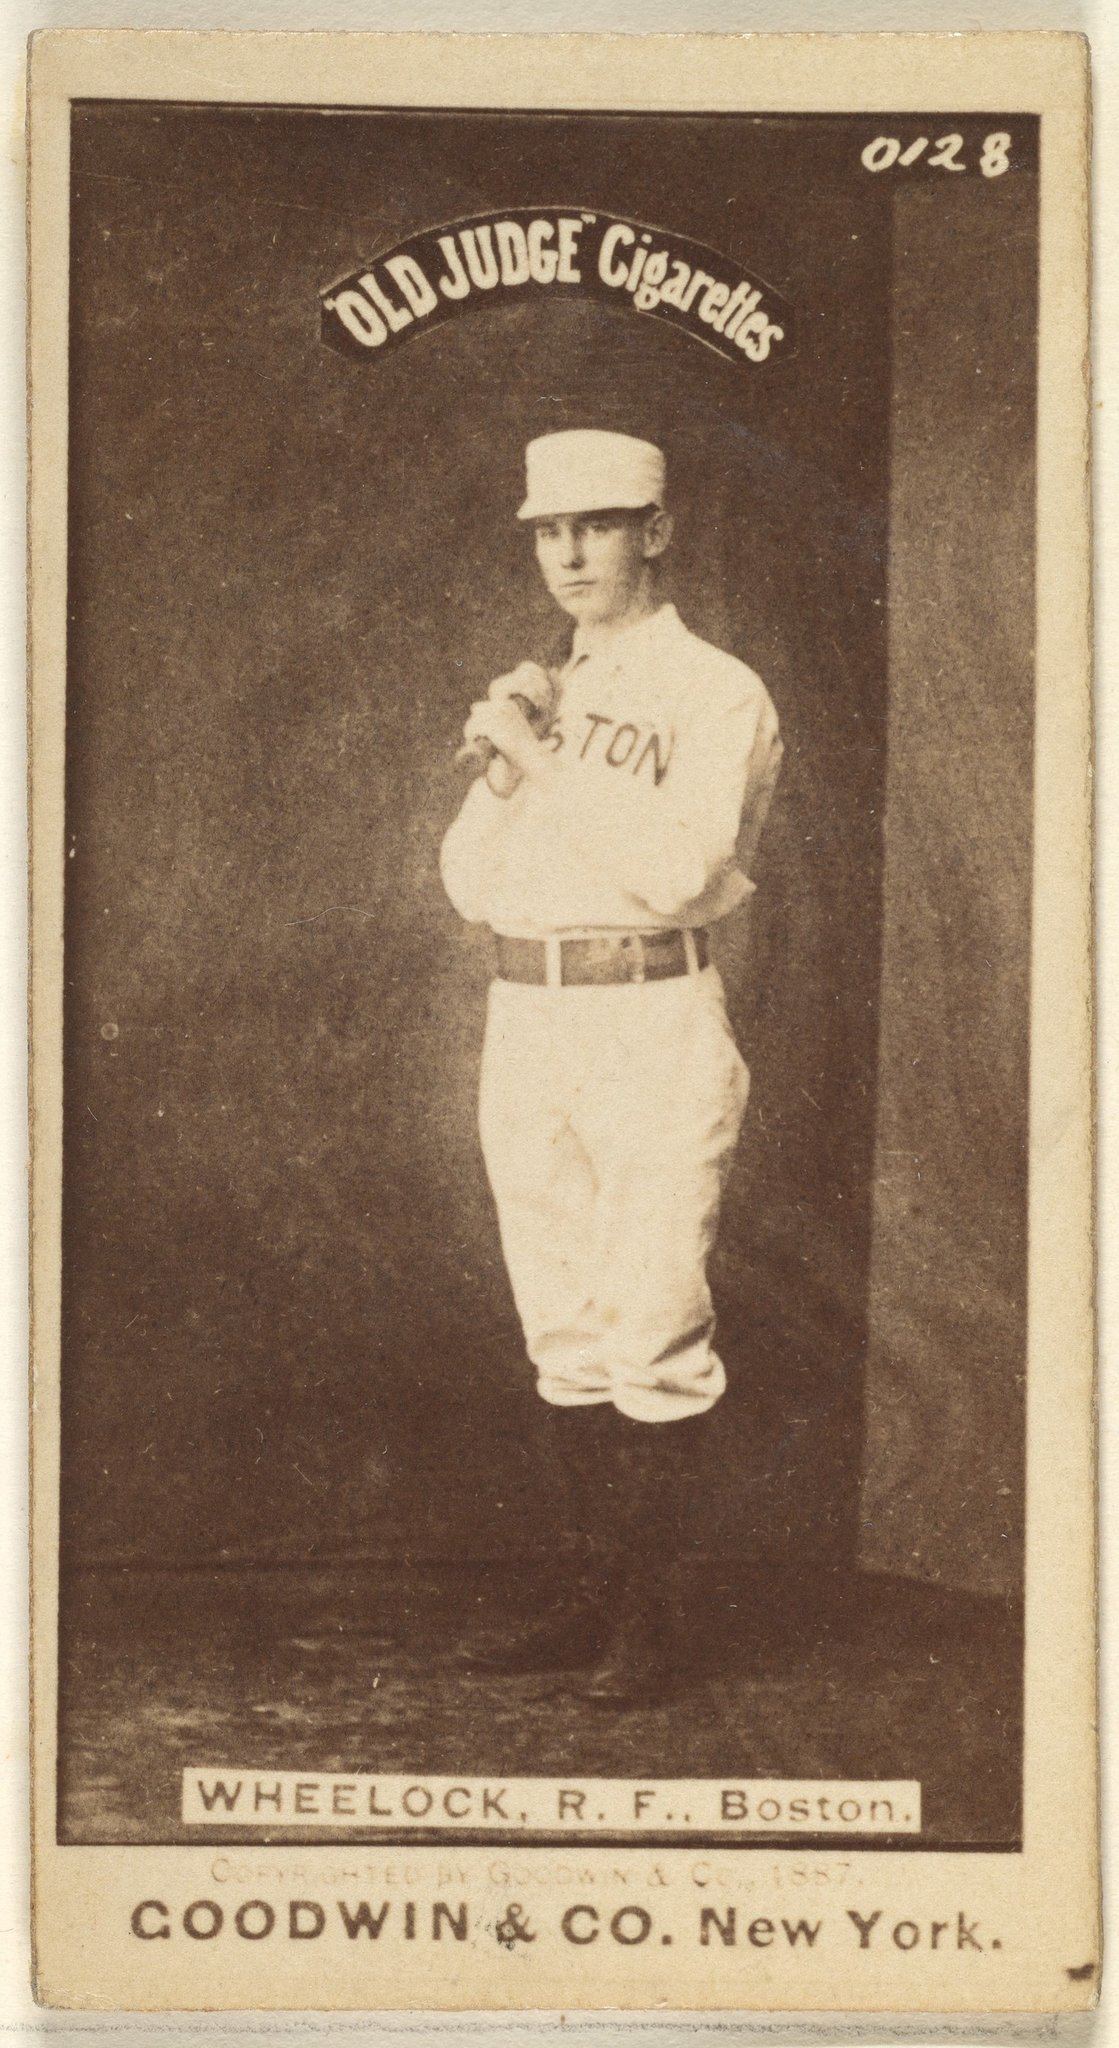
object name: baseball card, photograph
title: Wheelock, Right Field, Boston, from the Old Judge series (N172) for Old Judge Cigarettes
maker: goodwin & company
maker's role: publisher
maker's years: 1850-1950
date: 1887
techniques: albumen silver print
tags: men,portraits,baseball,athletes